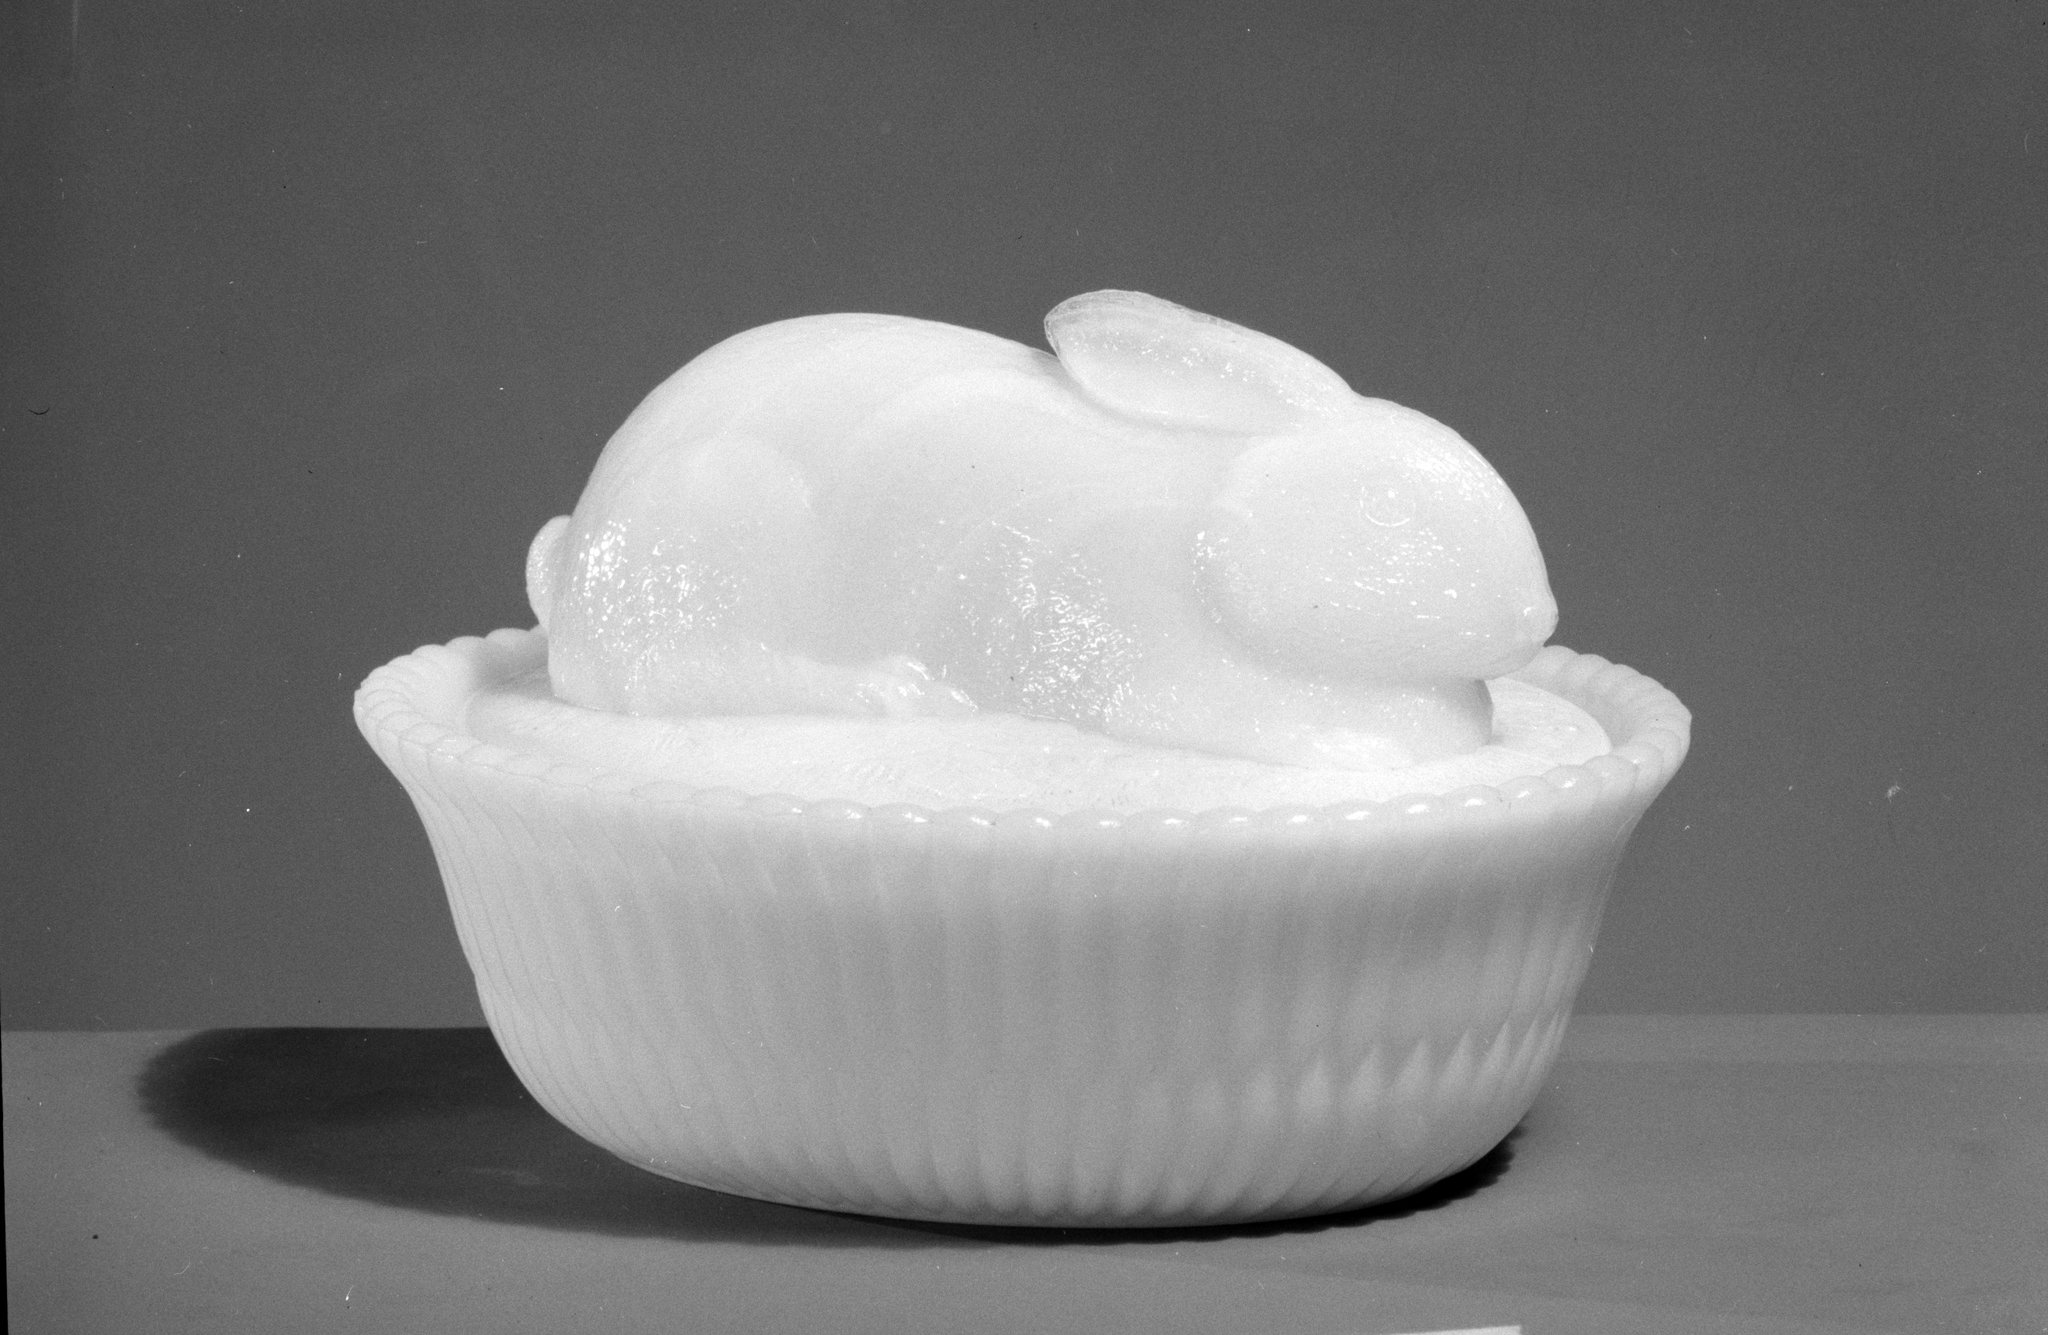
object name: dish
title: Figure Dish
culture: american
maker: mckee and brothers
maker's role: maker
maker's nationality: american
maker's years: 1856-1889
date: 1880-1890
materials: glass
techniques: pressed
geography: united states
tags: rabbits